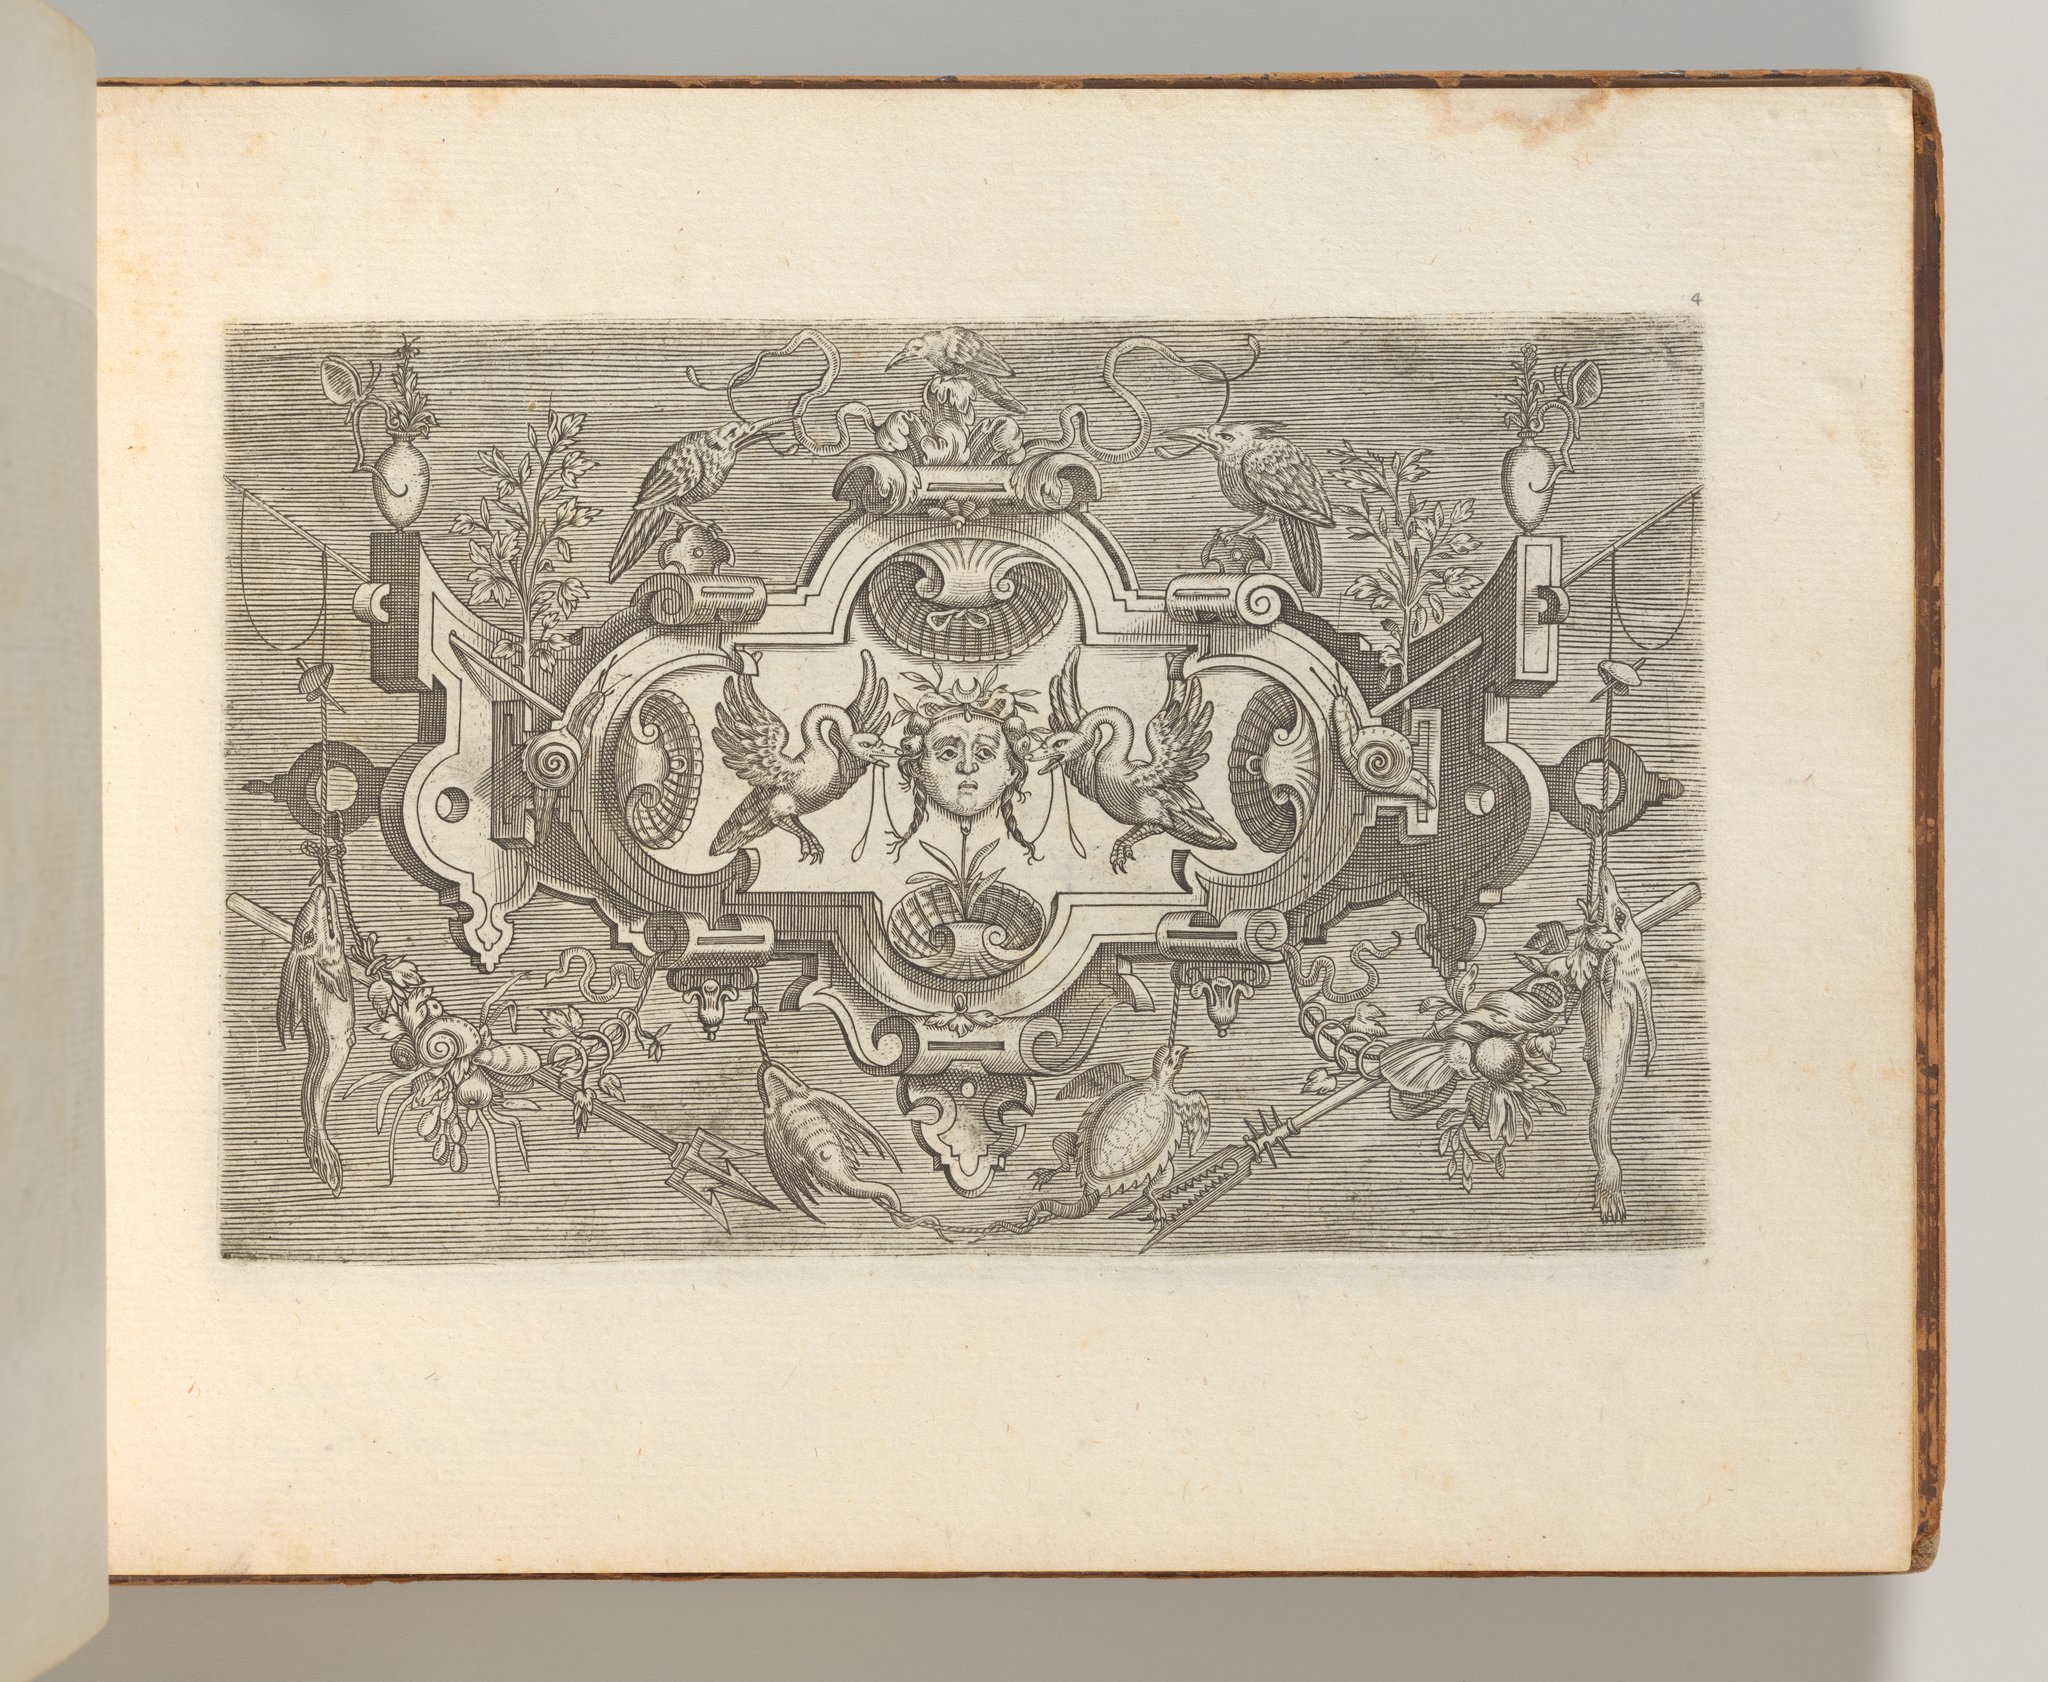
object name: album print ornament architecture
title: Targhe ed altri ornati di varie e capricciose invenzioni (Cartouches and other ornaments of various and capricious invention, page 4)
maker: jacob floris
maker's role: artist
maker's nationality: central european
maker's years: 1524-1581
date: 1773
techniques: engraving, etching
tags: birds,faces,swans